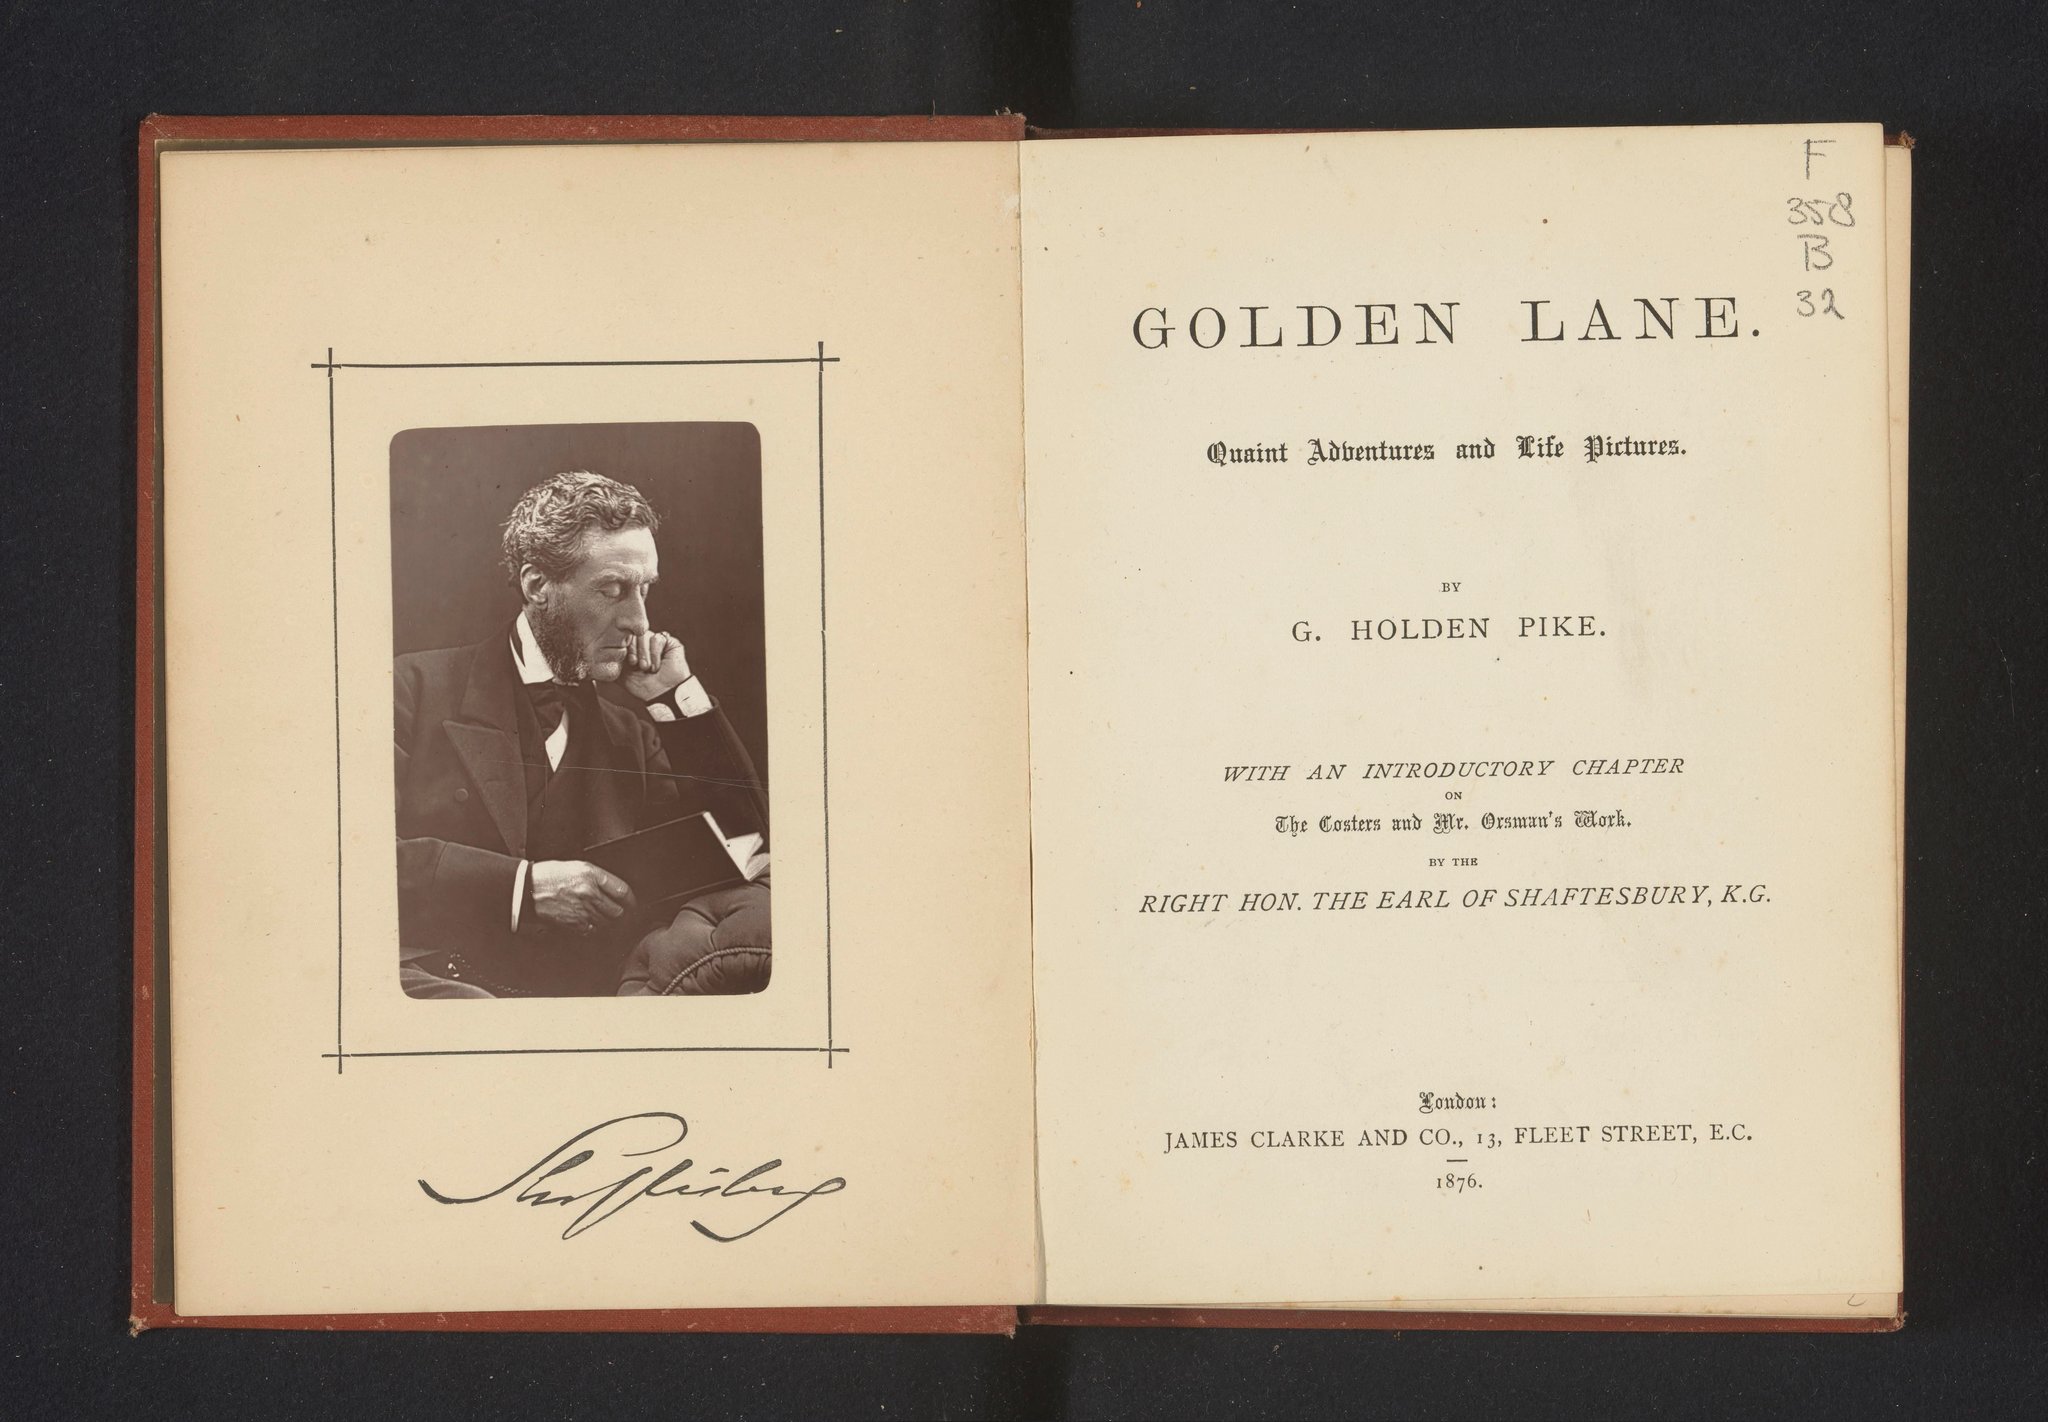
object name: book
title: Golden Lane : quaint adventures and life pictures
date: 1876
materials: cardboard, paper, textile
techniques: printing, engraving, woodburytype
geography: london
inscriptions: annotation: ‘JULY 2005’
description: Titel op omslag: Pictures of London life : the story of Mr. Orsman's mission in Golden Lane